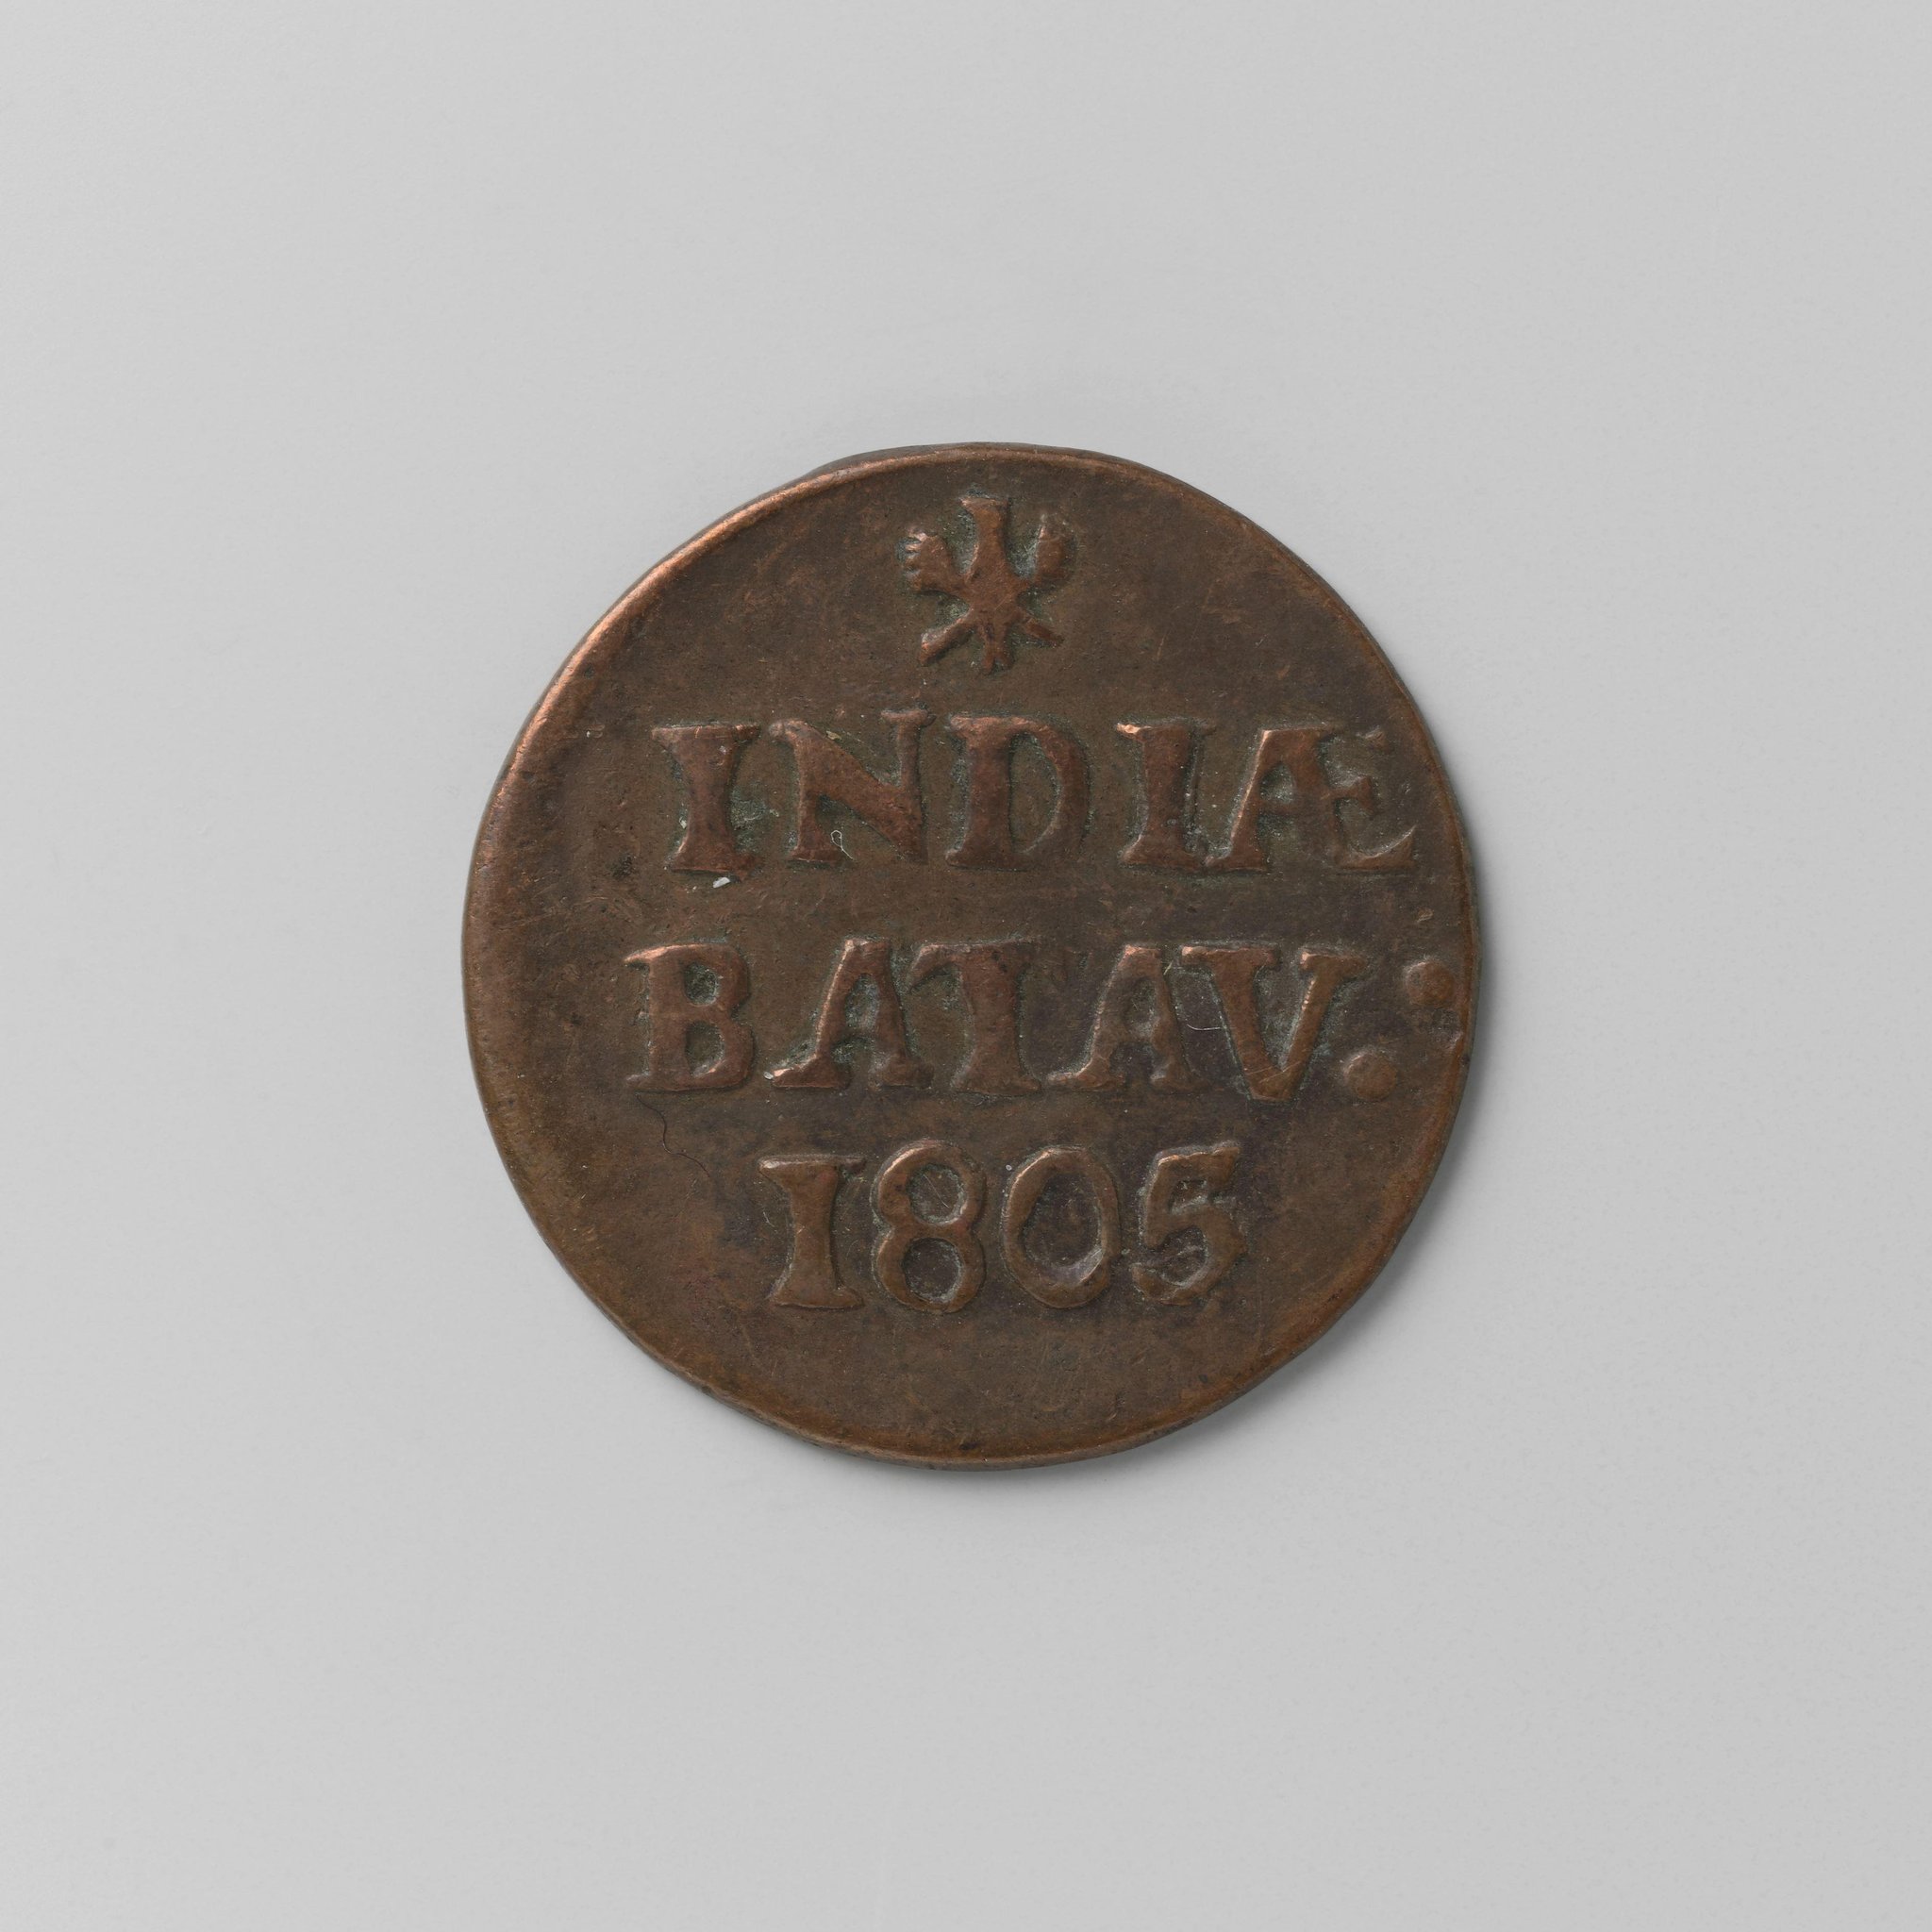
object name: coin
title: Nederlands Indië, duit Overijssel,1805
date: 1805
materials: copper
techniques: striking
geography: kampen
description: Koperen munt. Voorzijde: tweeregelig opschrift, waarboven muntmeesterteken en waaronder jaartal. Keerzijde: binnen wapenspreuk tussen waarde-aanduiding 5 1/16 G gekroond wapenschild van Overijssel. Gladde rand.